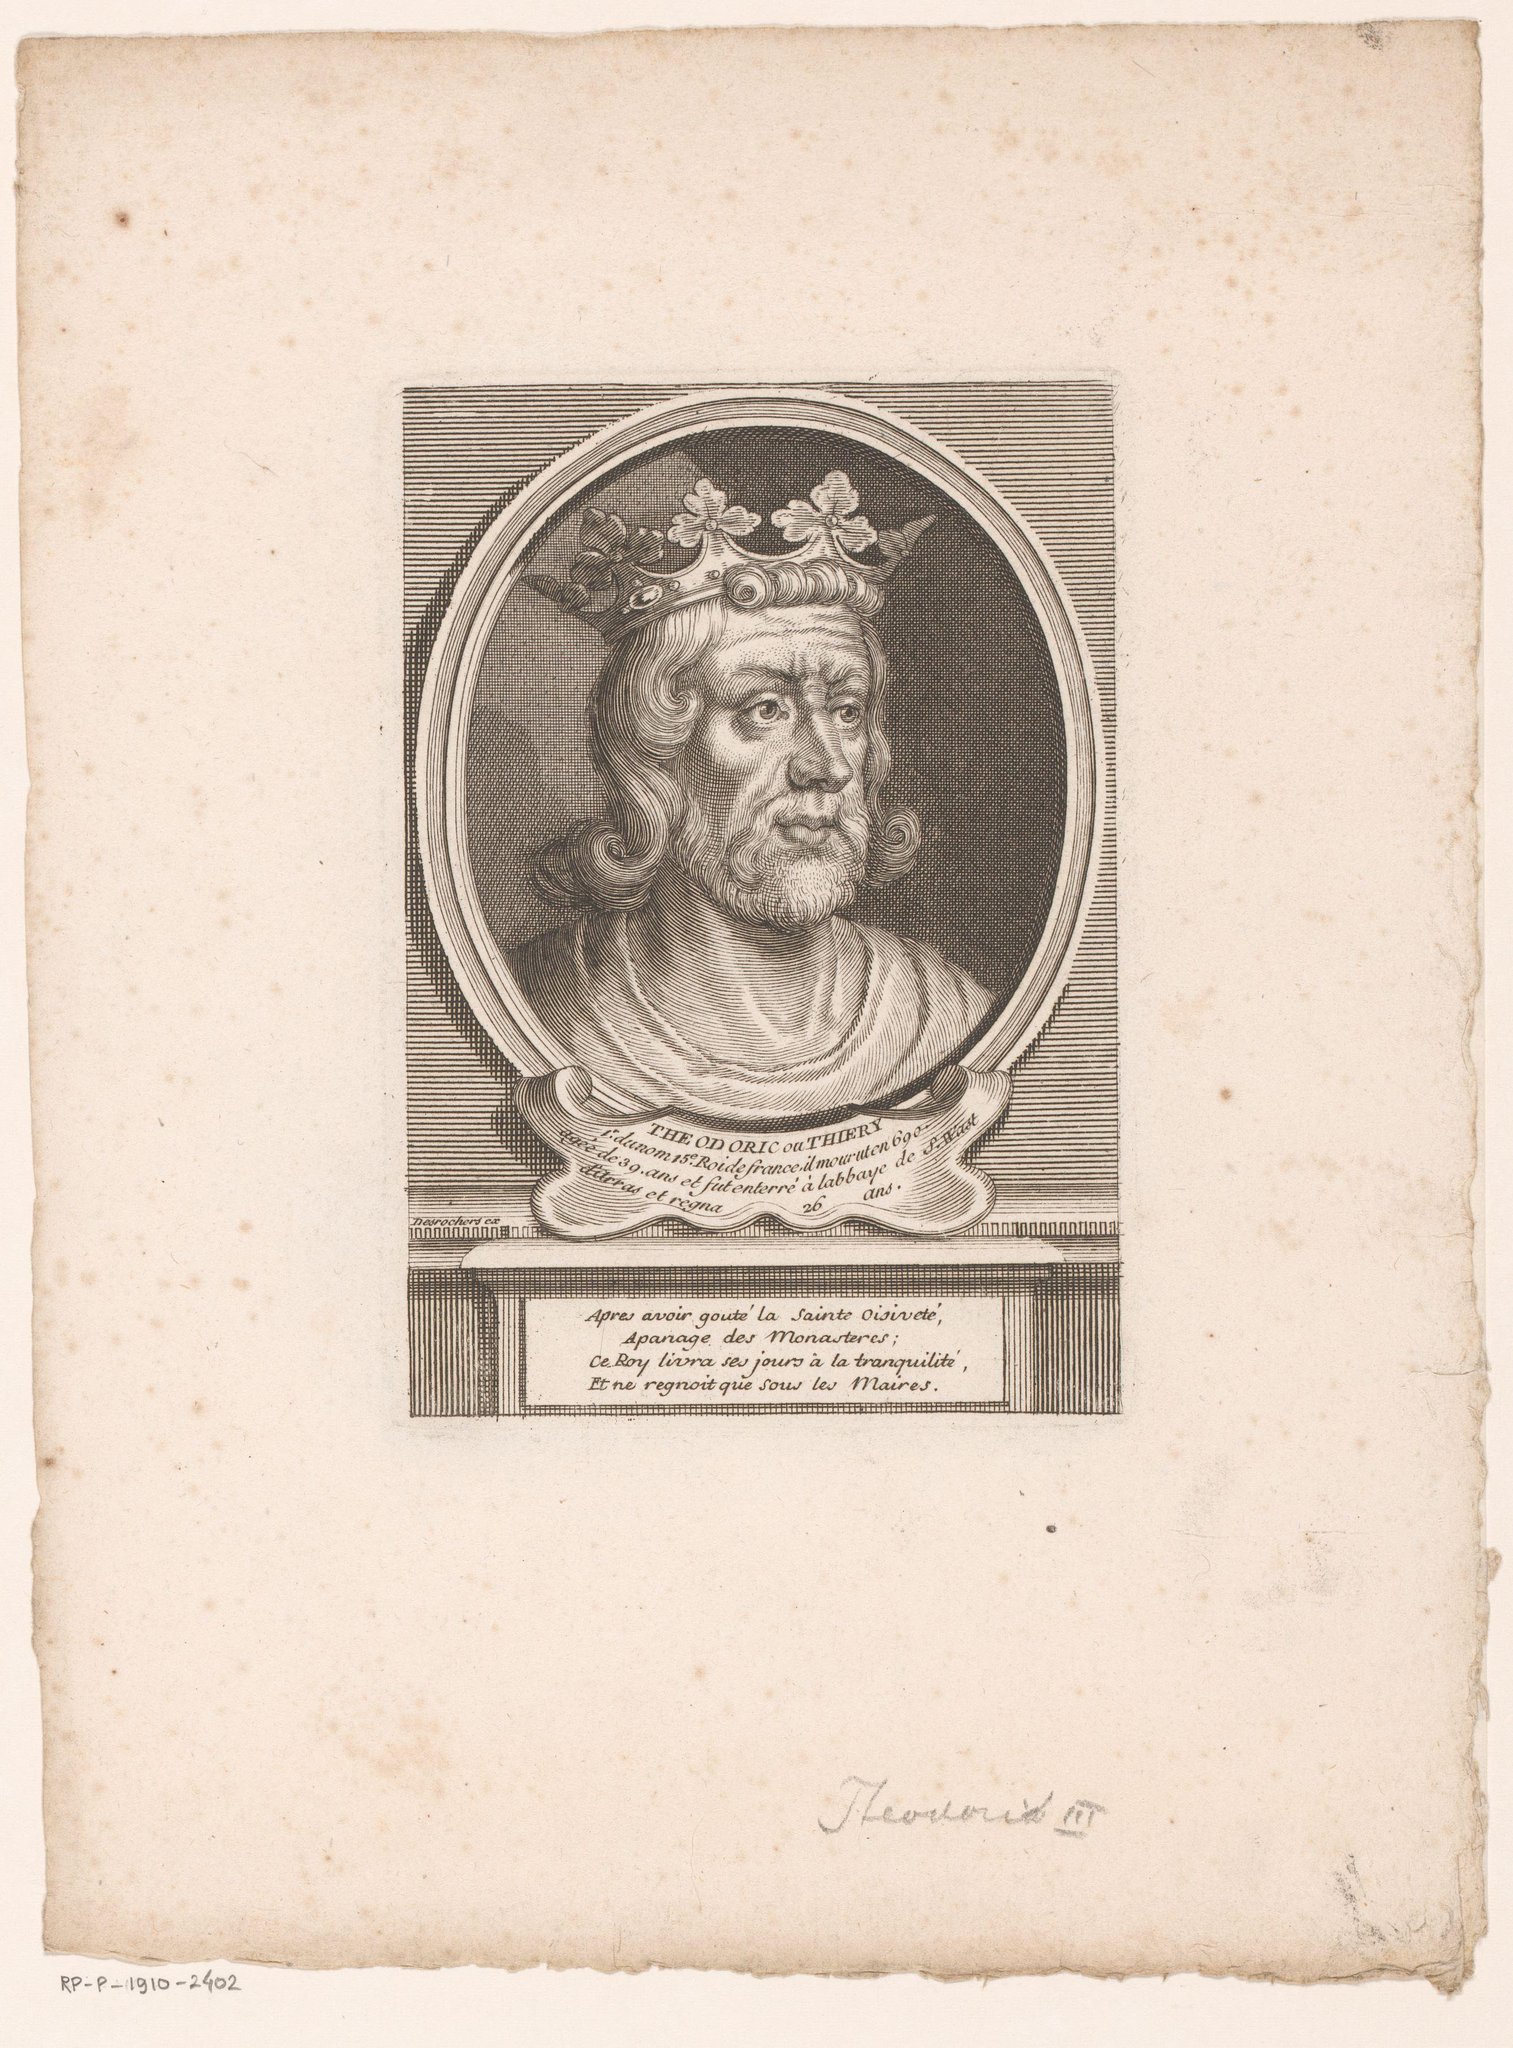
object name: print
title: Verzameling portretten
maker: étienne desrochers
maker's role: print maker, publisher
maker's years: 1668-1741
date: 1726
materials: paper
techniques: engraving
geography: paris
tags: historical persons, king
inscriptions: collector's mark: Lugt 2228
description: Behoort waarschijnlijk tot een serie portretten, grotendeels door Etienne Desrochers, getiteld: 'Recueil de portraits de personnes qui se sont distinguées tant dans les Armes que dans Belles-Lettres et les Arts, comme aussi la famille royale de France et autres cours étrangères'. De serie werd initieel uitgegeven door Desrochers en aangekondigd in 'Mercure' in mei 1726, p. 985. Echter was Desrochers reeds enkele jaren eerder begonnen met het uitgeven van de serie. Na de dood van Desrochers werd de serie voortgezet door Gilles Edme Petit. Een latere staat werd uitgegeven door Jean François Daumont in Parijs.